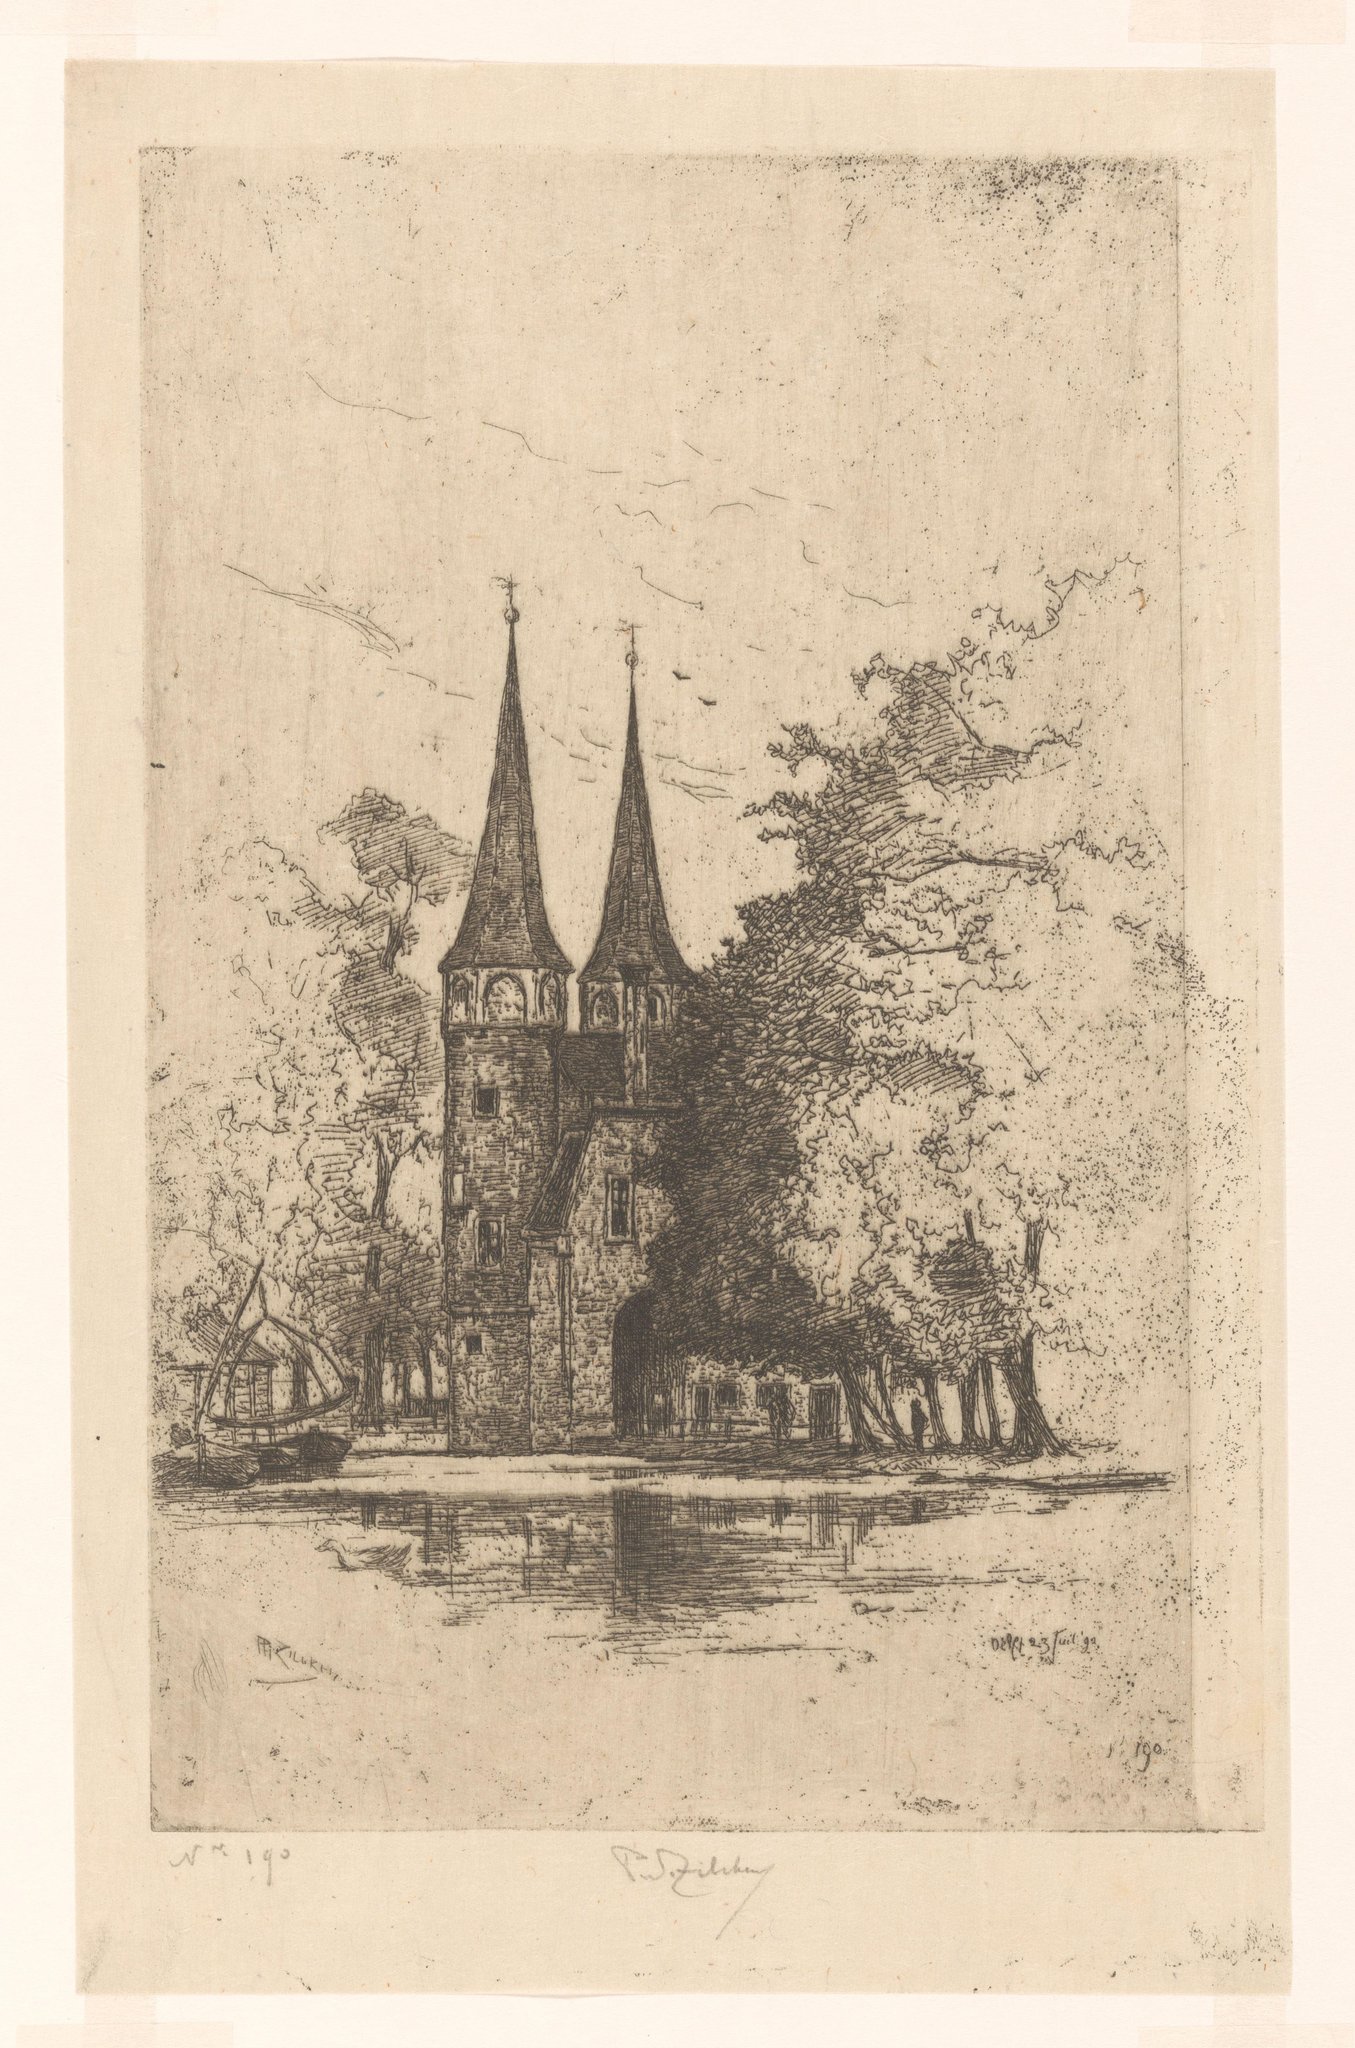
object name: print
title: Gezicht op de Oostpoort, te Delft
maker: philip zilcken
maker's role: draughtsman, painter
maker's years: 1857-1930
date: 1890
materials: paper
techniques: etching, intaglio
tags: city-gate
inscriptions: date